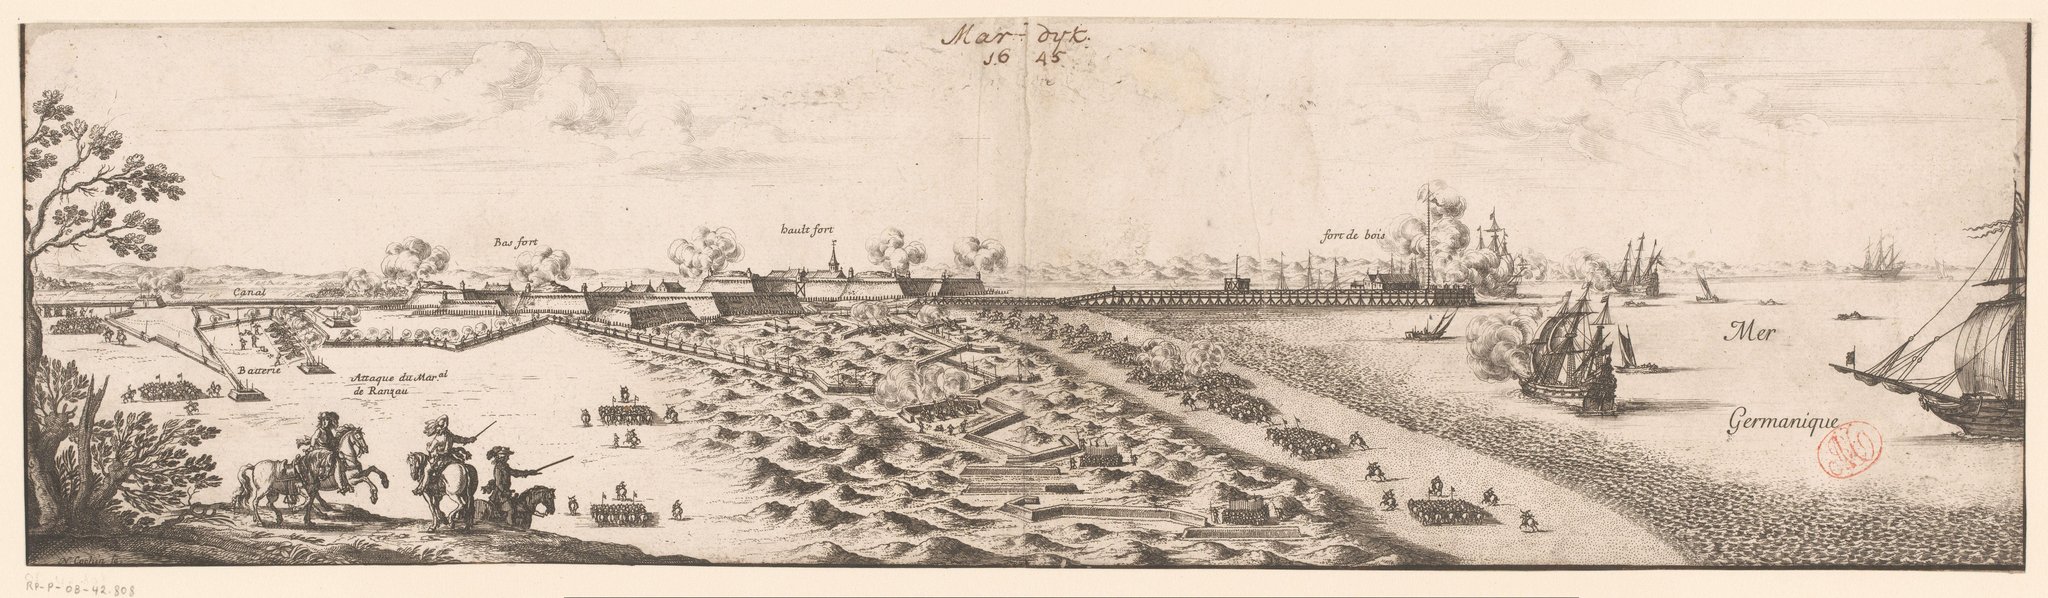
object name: print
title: Plattegrond van Mardijk, 1645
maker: nicolas cochin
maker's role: print maker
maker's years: 1610-1686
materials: paper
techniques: etching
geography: france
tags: siege, position war, maps of cities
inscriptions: title: ‘Mardyk. 1645’, collector's mark: Lugt 195